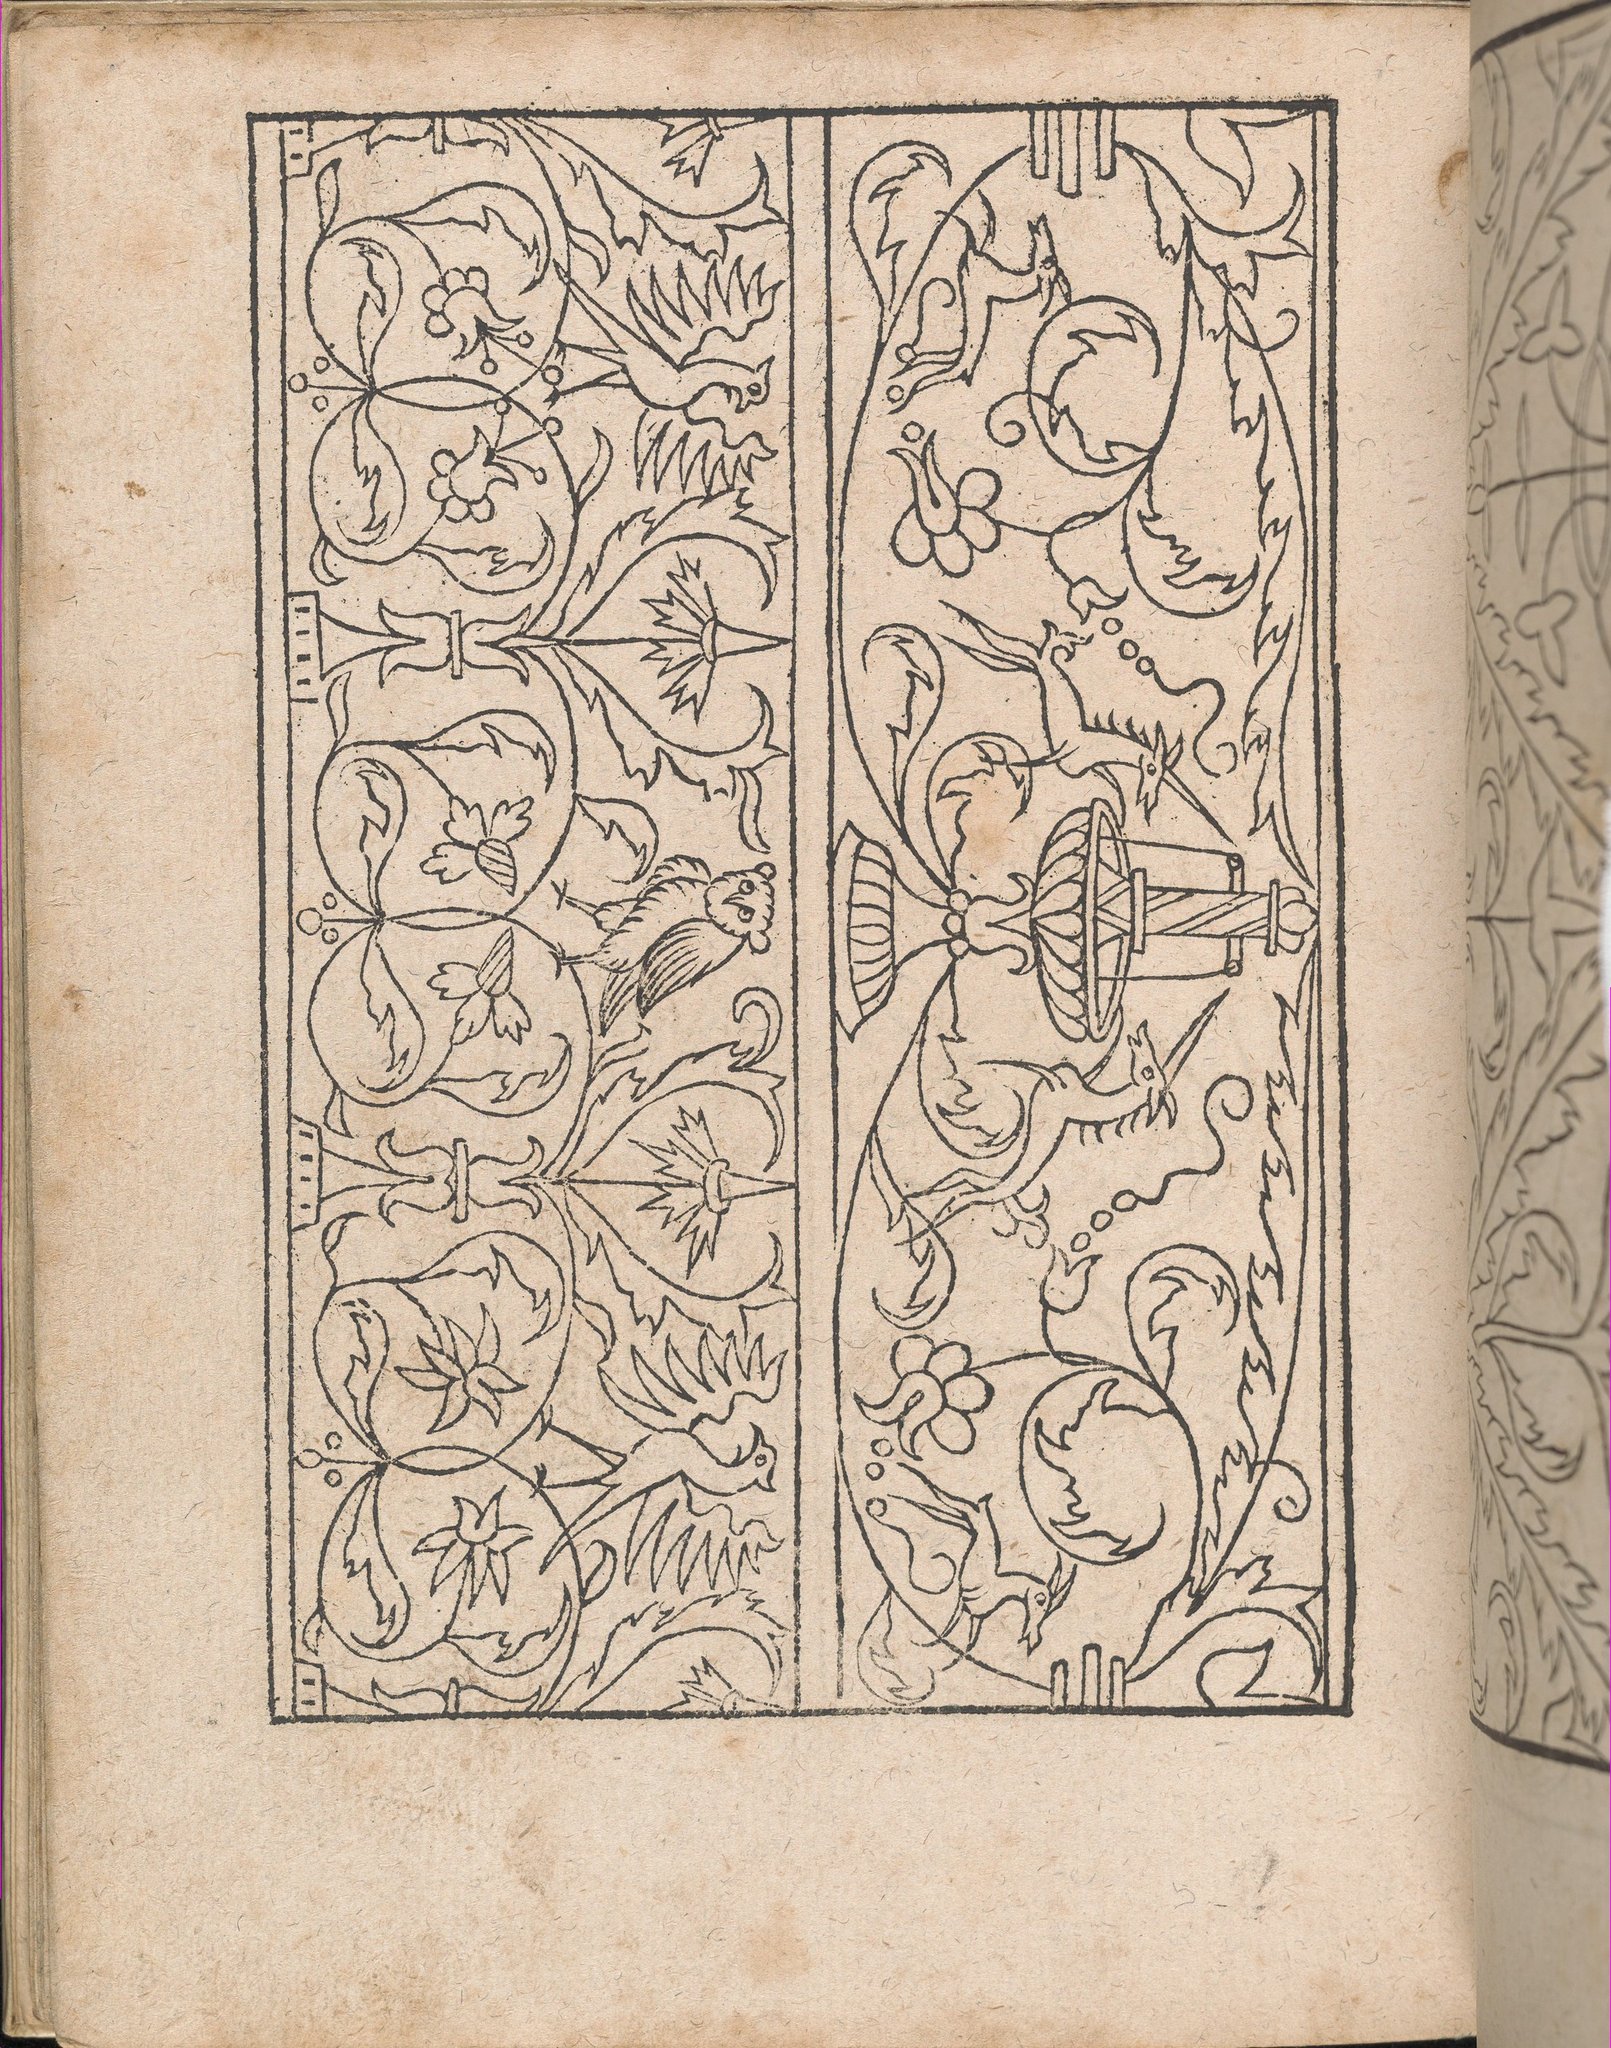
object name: book print ornament architecture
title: New Modelbüch allen Nägerin u. Sydenstickern (Page 24v)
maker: hans hoffman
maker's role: designer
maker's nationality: german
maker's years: 1556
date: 1556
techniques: woodcut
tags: birds,ornament,unicorns,owls